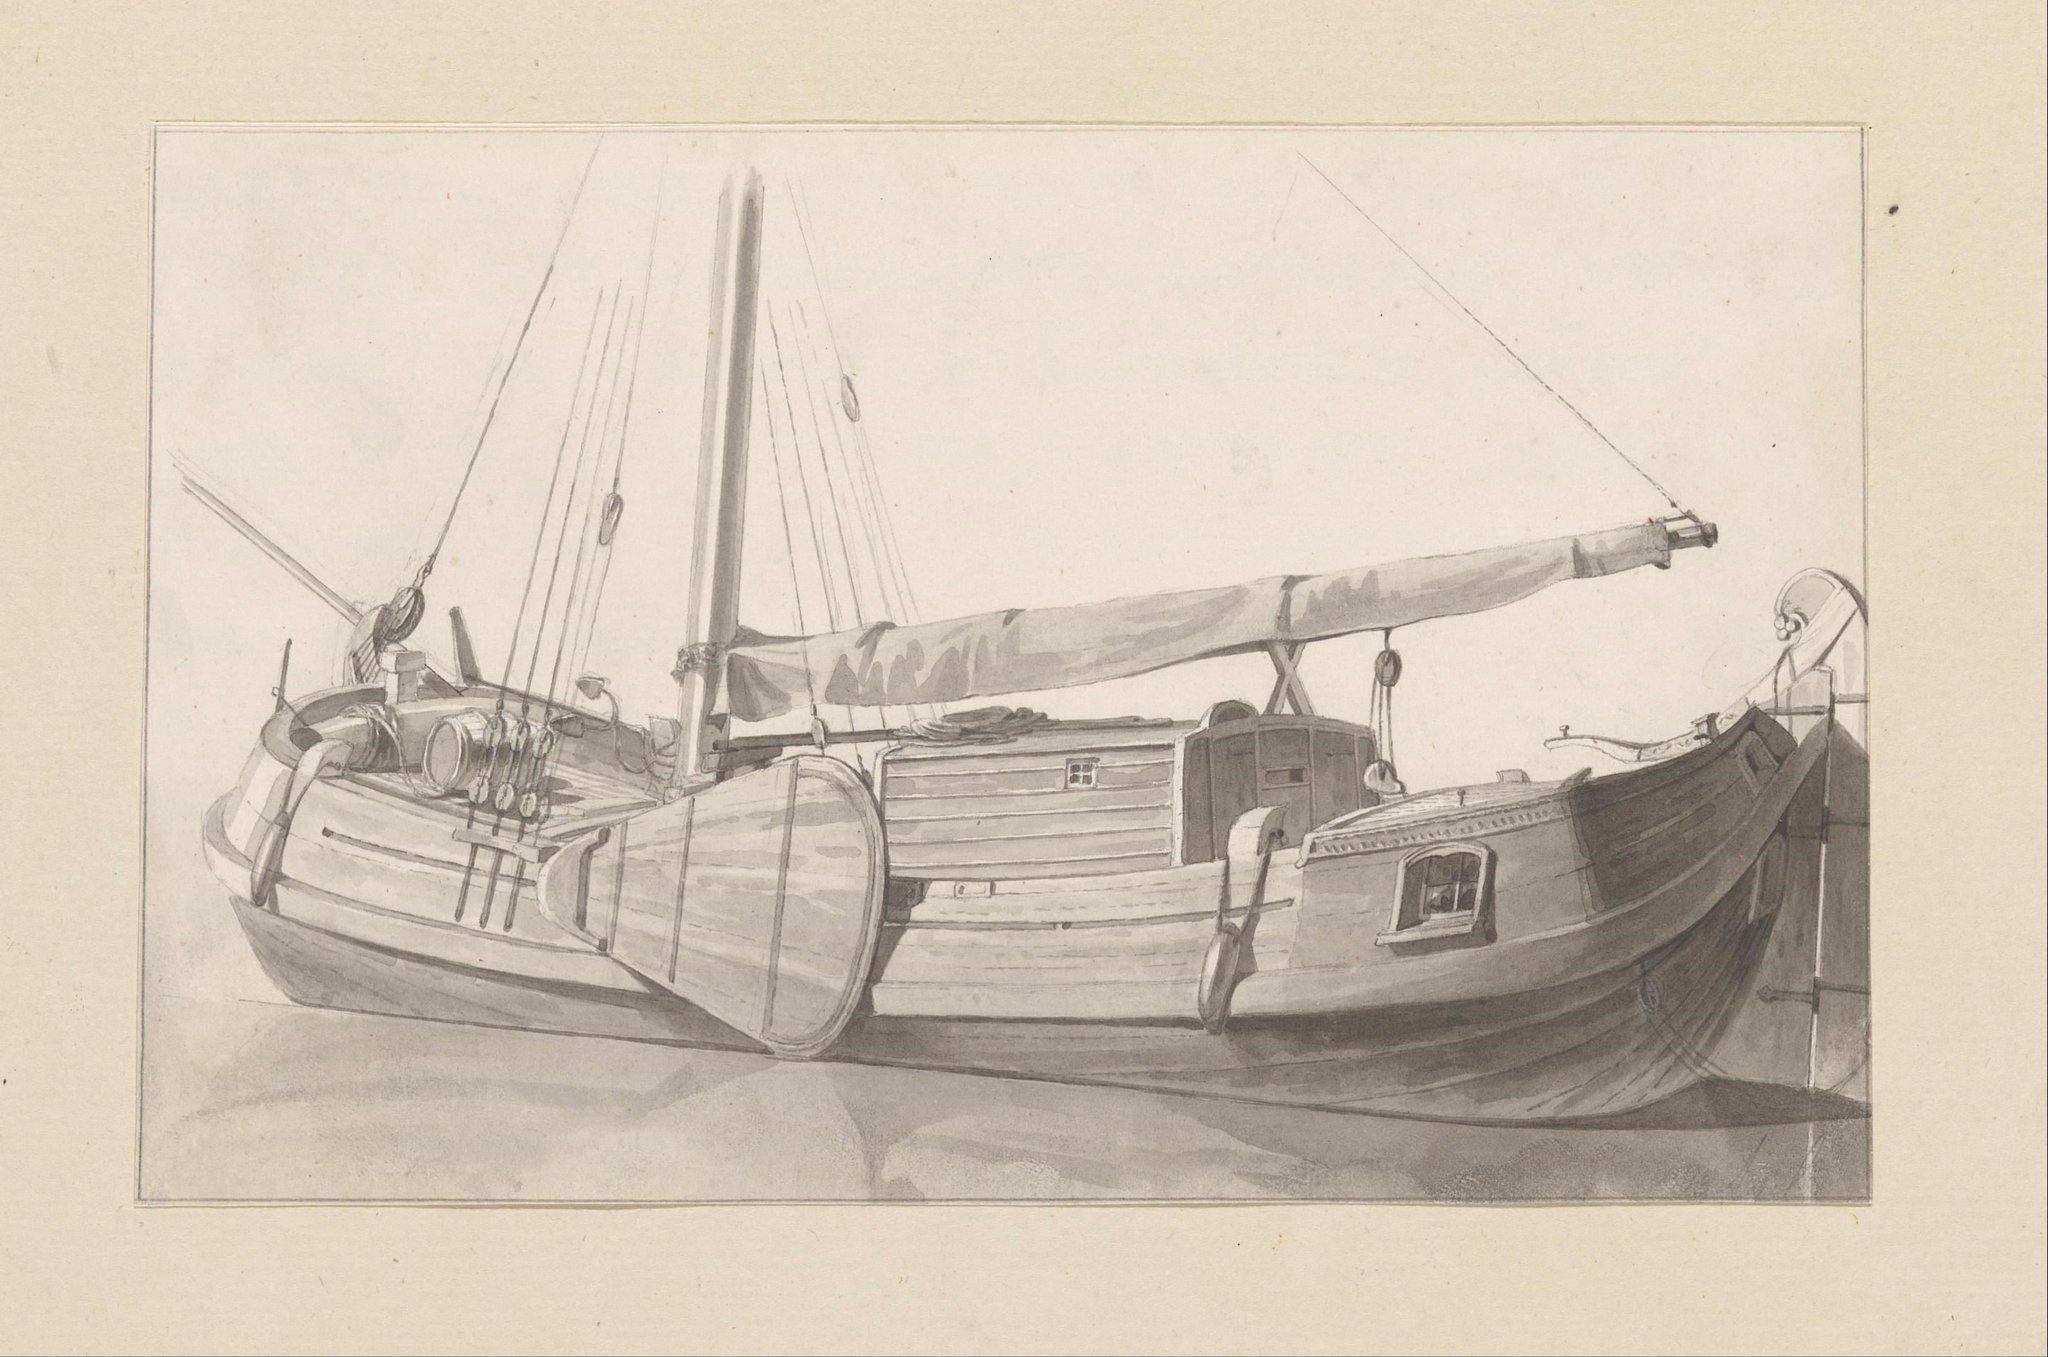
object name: drawing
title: Zeilschip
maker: hendrik abraham klinkhamer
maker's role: draughtsman, painter, print maker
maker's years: 1810-1872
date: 1820-1872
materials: paper, pencil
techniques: brush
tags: sailing-ship, sailing-boat